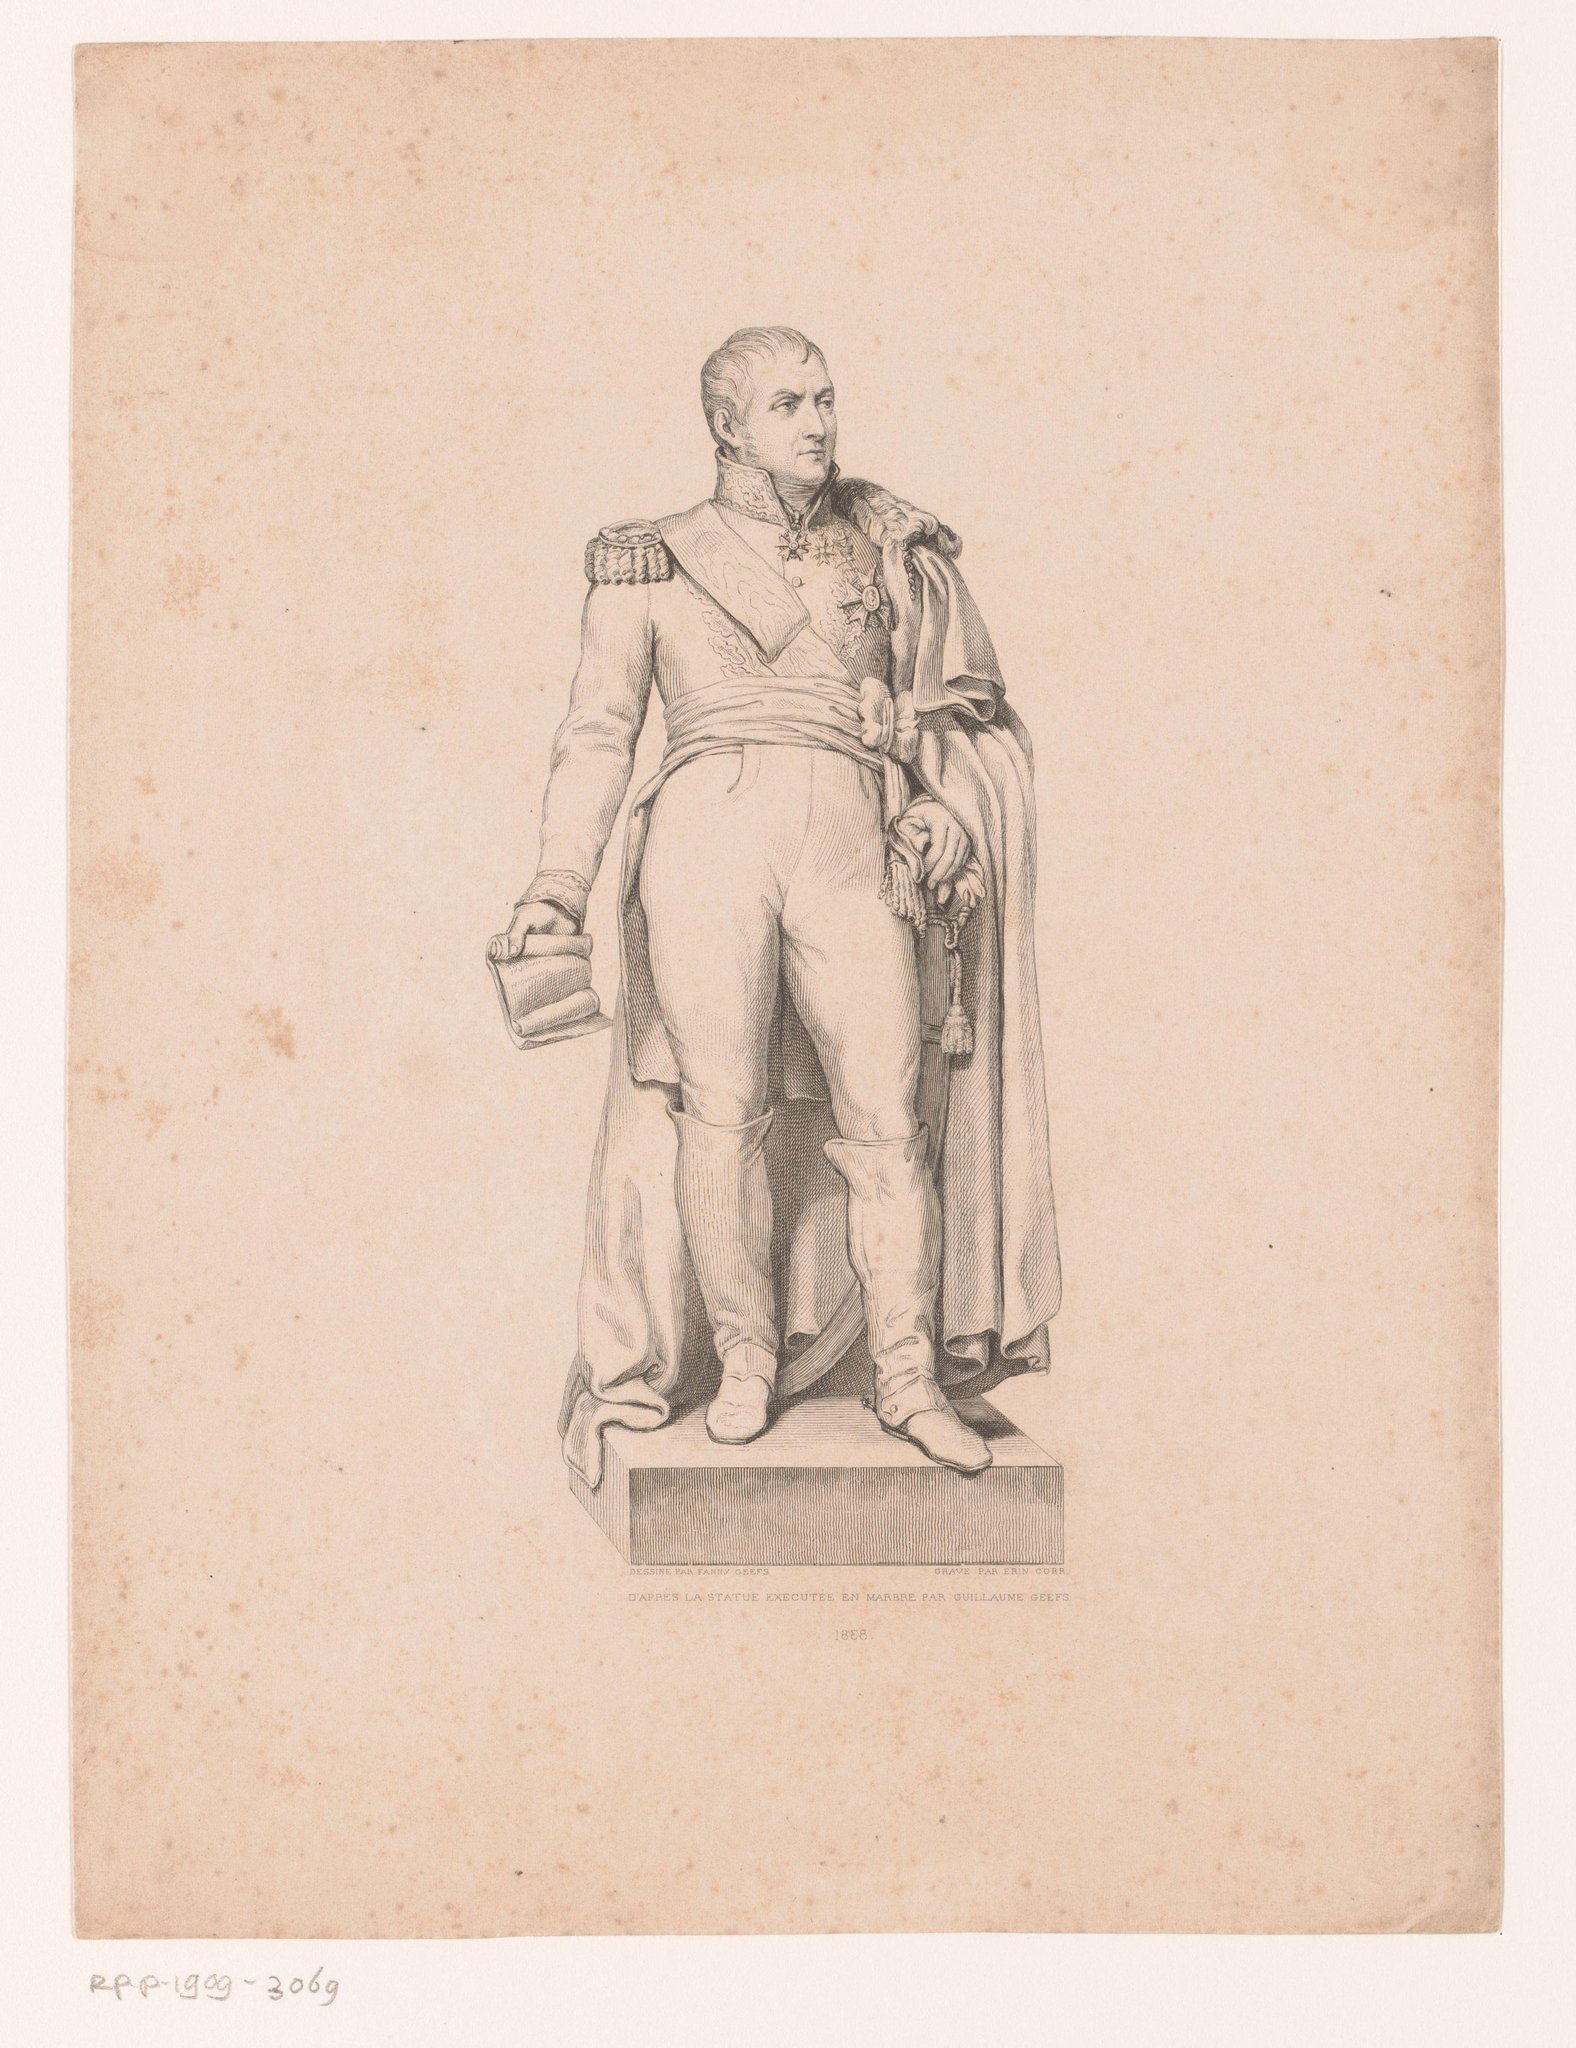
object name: print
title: Standbeeld van Augustin Daniel Belliard te Brussel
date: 1838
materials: paper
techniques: etching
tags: brussels, monument, statue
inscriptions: collector's mark: Lugt 2228